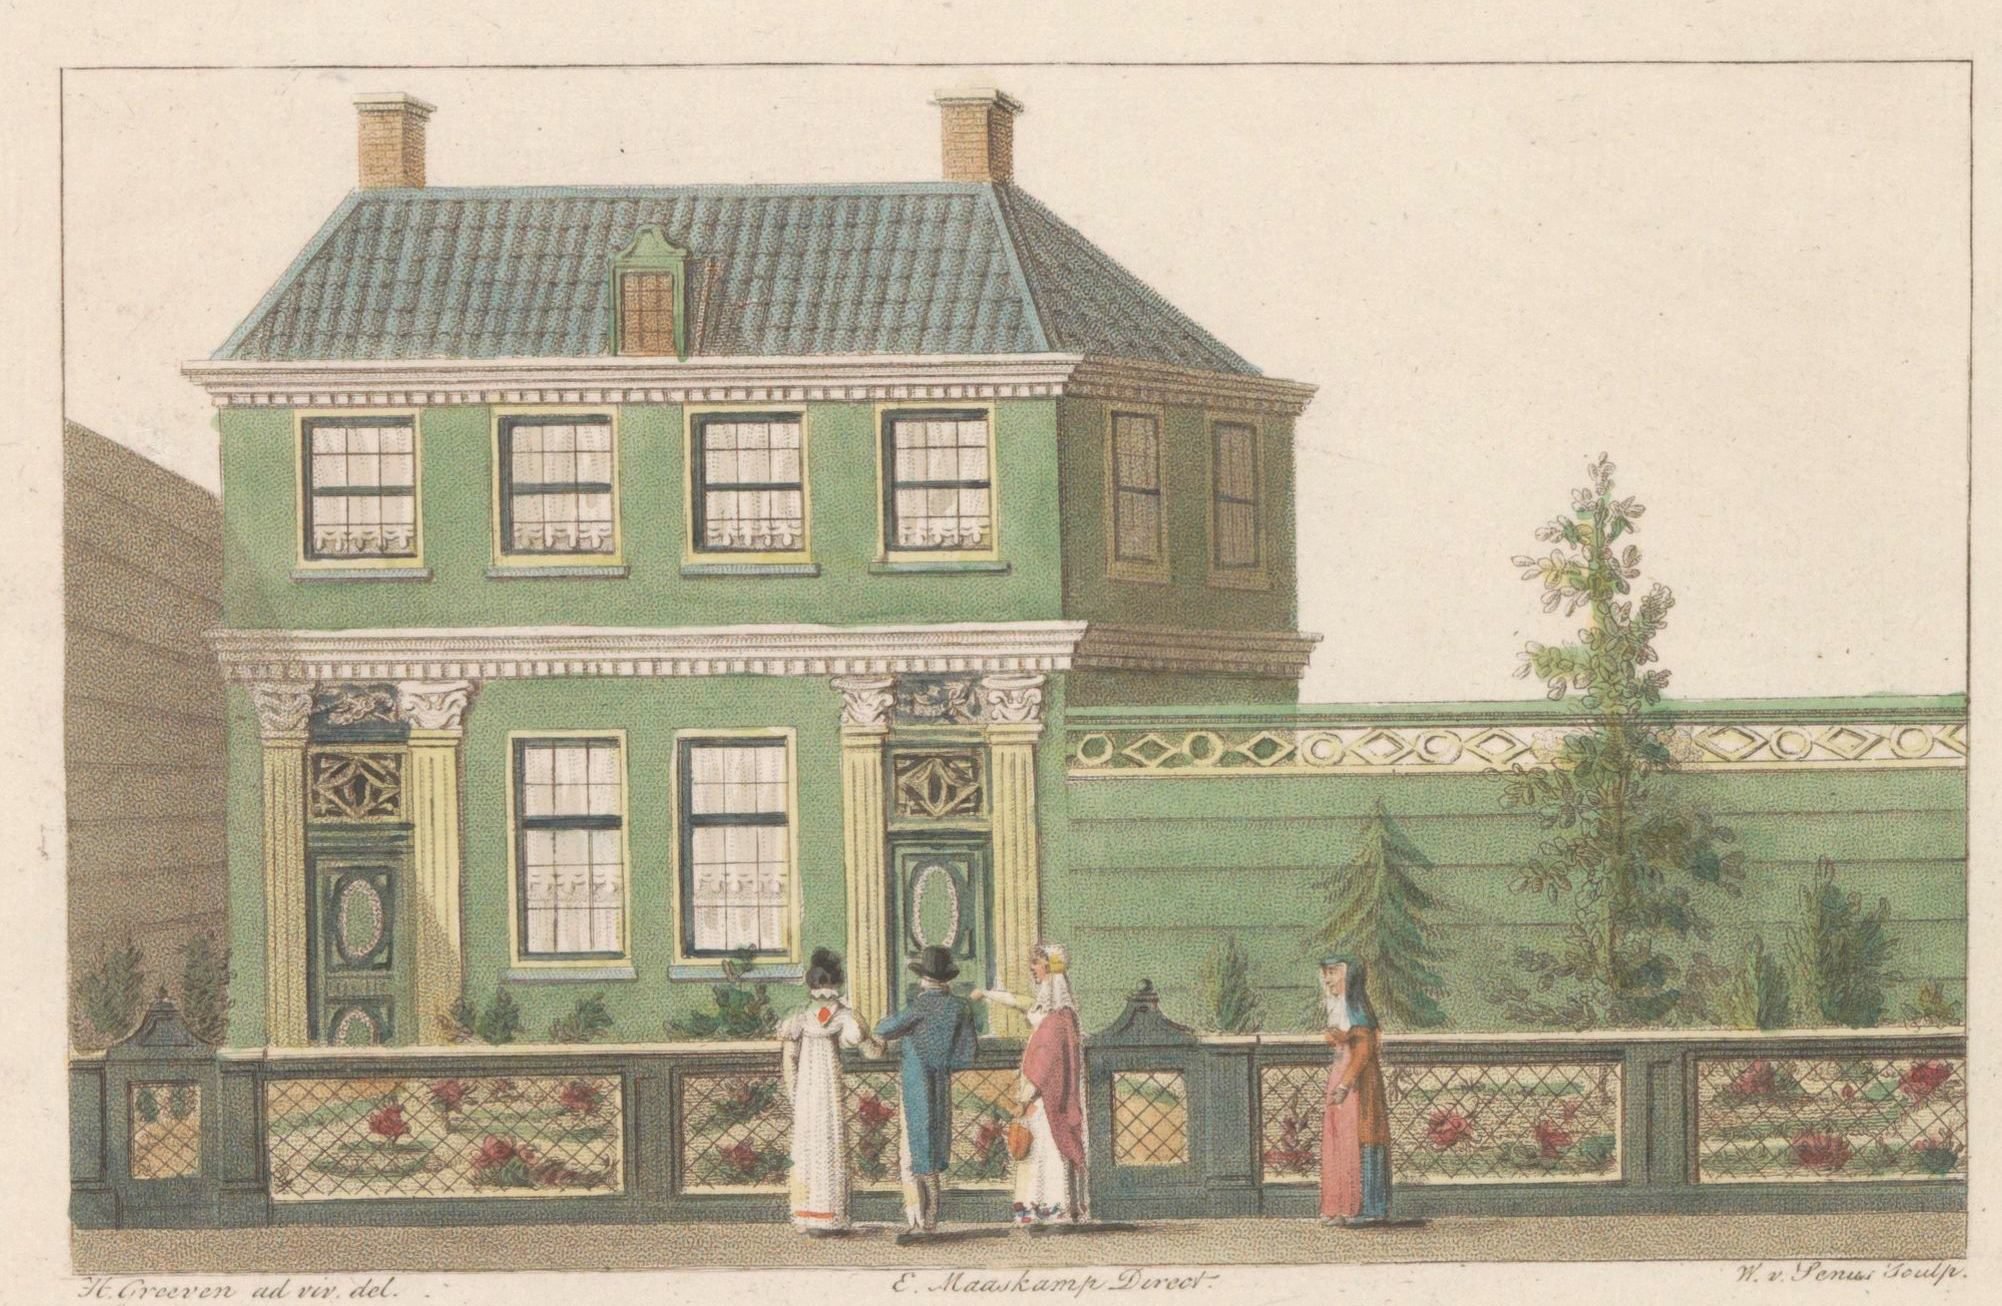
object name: print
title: Eene Afbeelding van eene Noord-Hollandsche woning te Zaandam / Representation d'une maison d'un riche particulier à Zaandam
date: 1824-1825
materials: paper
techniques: aquatint, etching, hand coloring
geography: netherlands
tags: villa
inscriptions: inscription: ‘Representation d'une maison d'un riche particulier à Zaandam’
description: Op een exemplaar in de collectie Prenten en Tekeningen Provinciale Atlas Noord-Holland (nr. 359_3660) staat op een bijgevoegd bijschrift: 'Dit Huis deed bouwen de Heer Adriaan Duin Pz., 1806, later bewoond door zijn schoonzoon de Edel Achtbare Heer Jan Vander, en thans, 1847, door Mejufvrouw de Weduwe Dirk van Voorst".